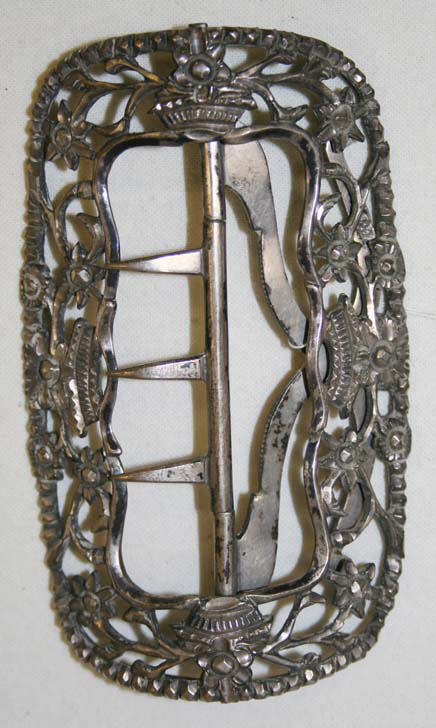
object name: buckle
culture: dutch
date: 1804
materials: metal